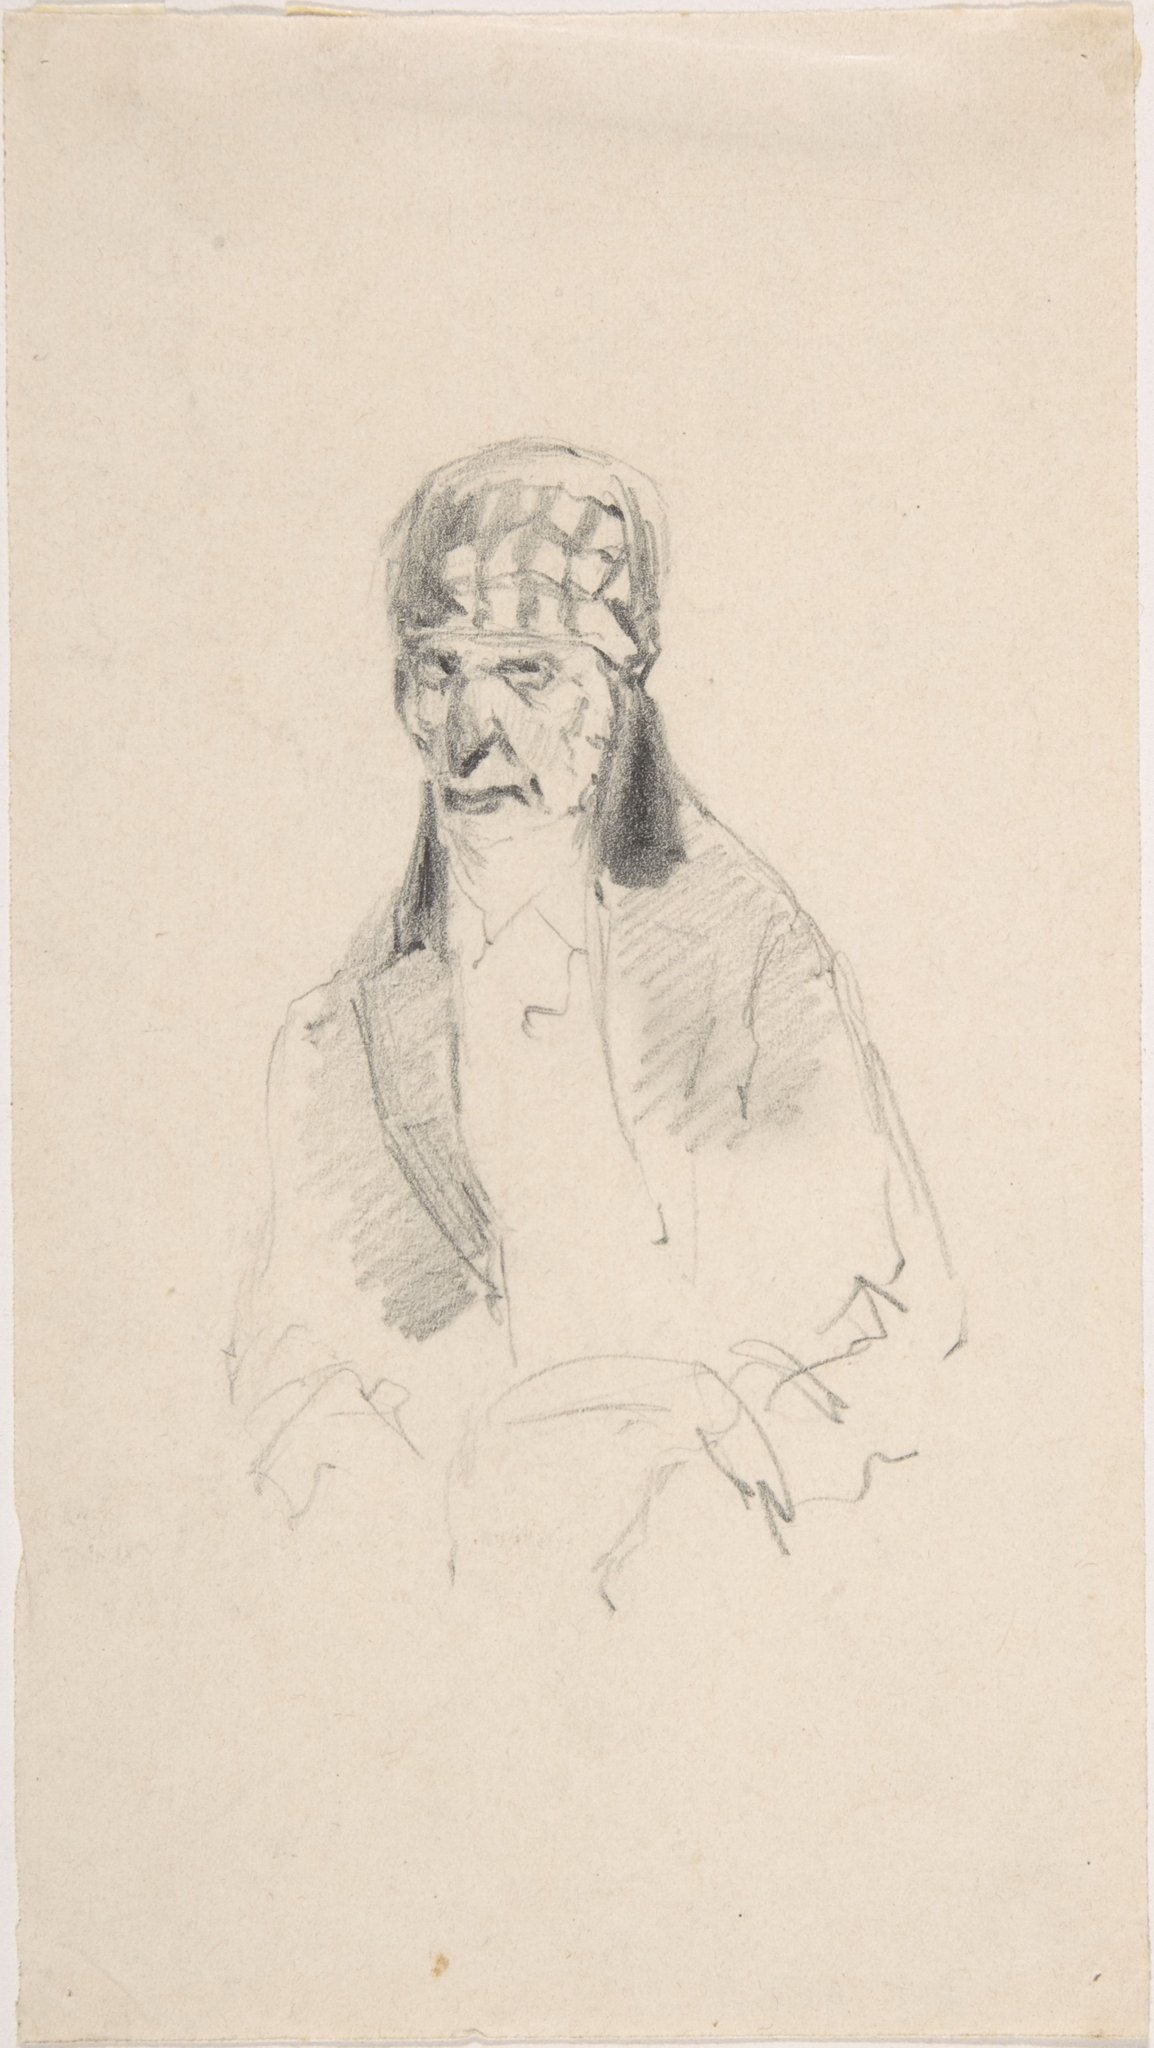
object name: drawing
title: Man with a Turban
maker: félicien rops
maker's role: artist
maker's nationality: belgian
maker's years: 1833-1898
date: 1833-1898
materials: graphite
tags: men,portraits